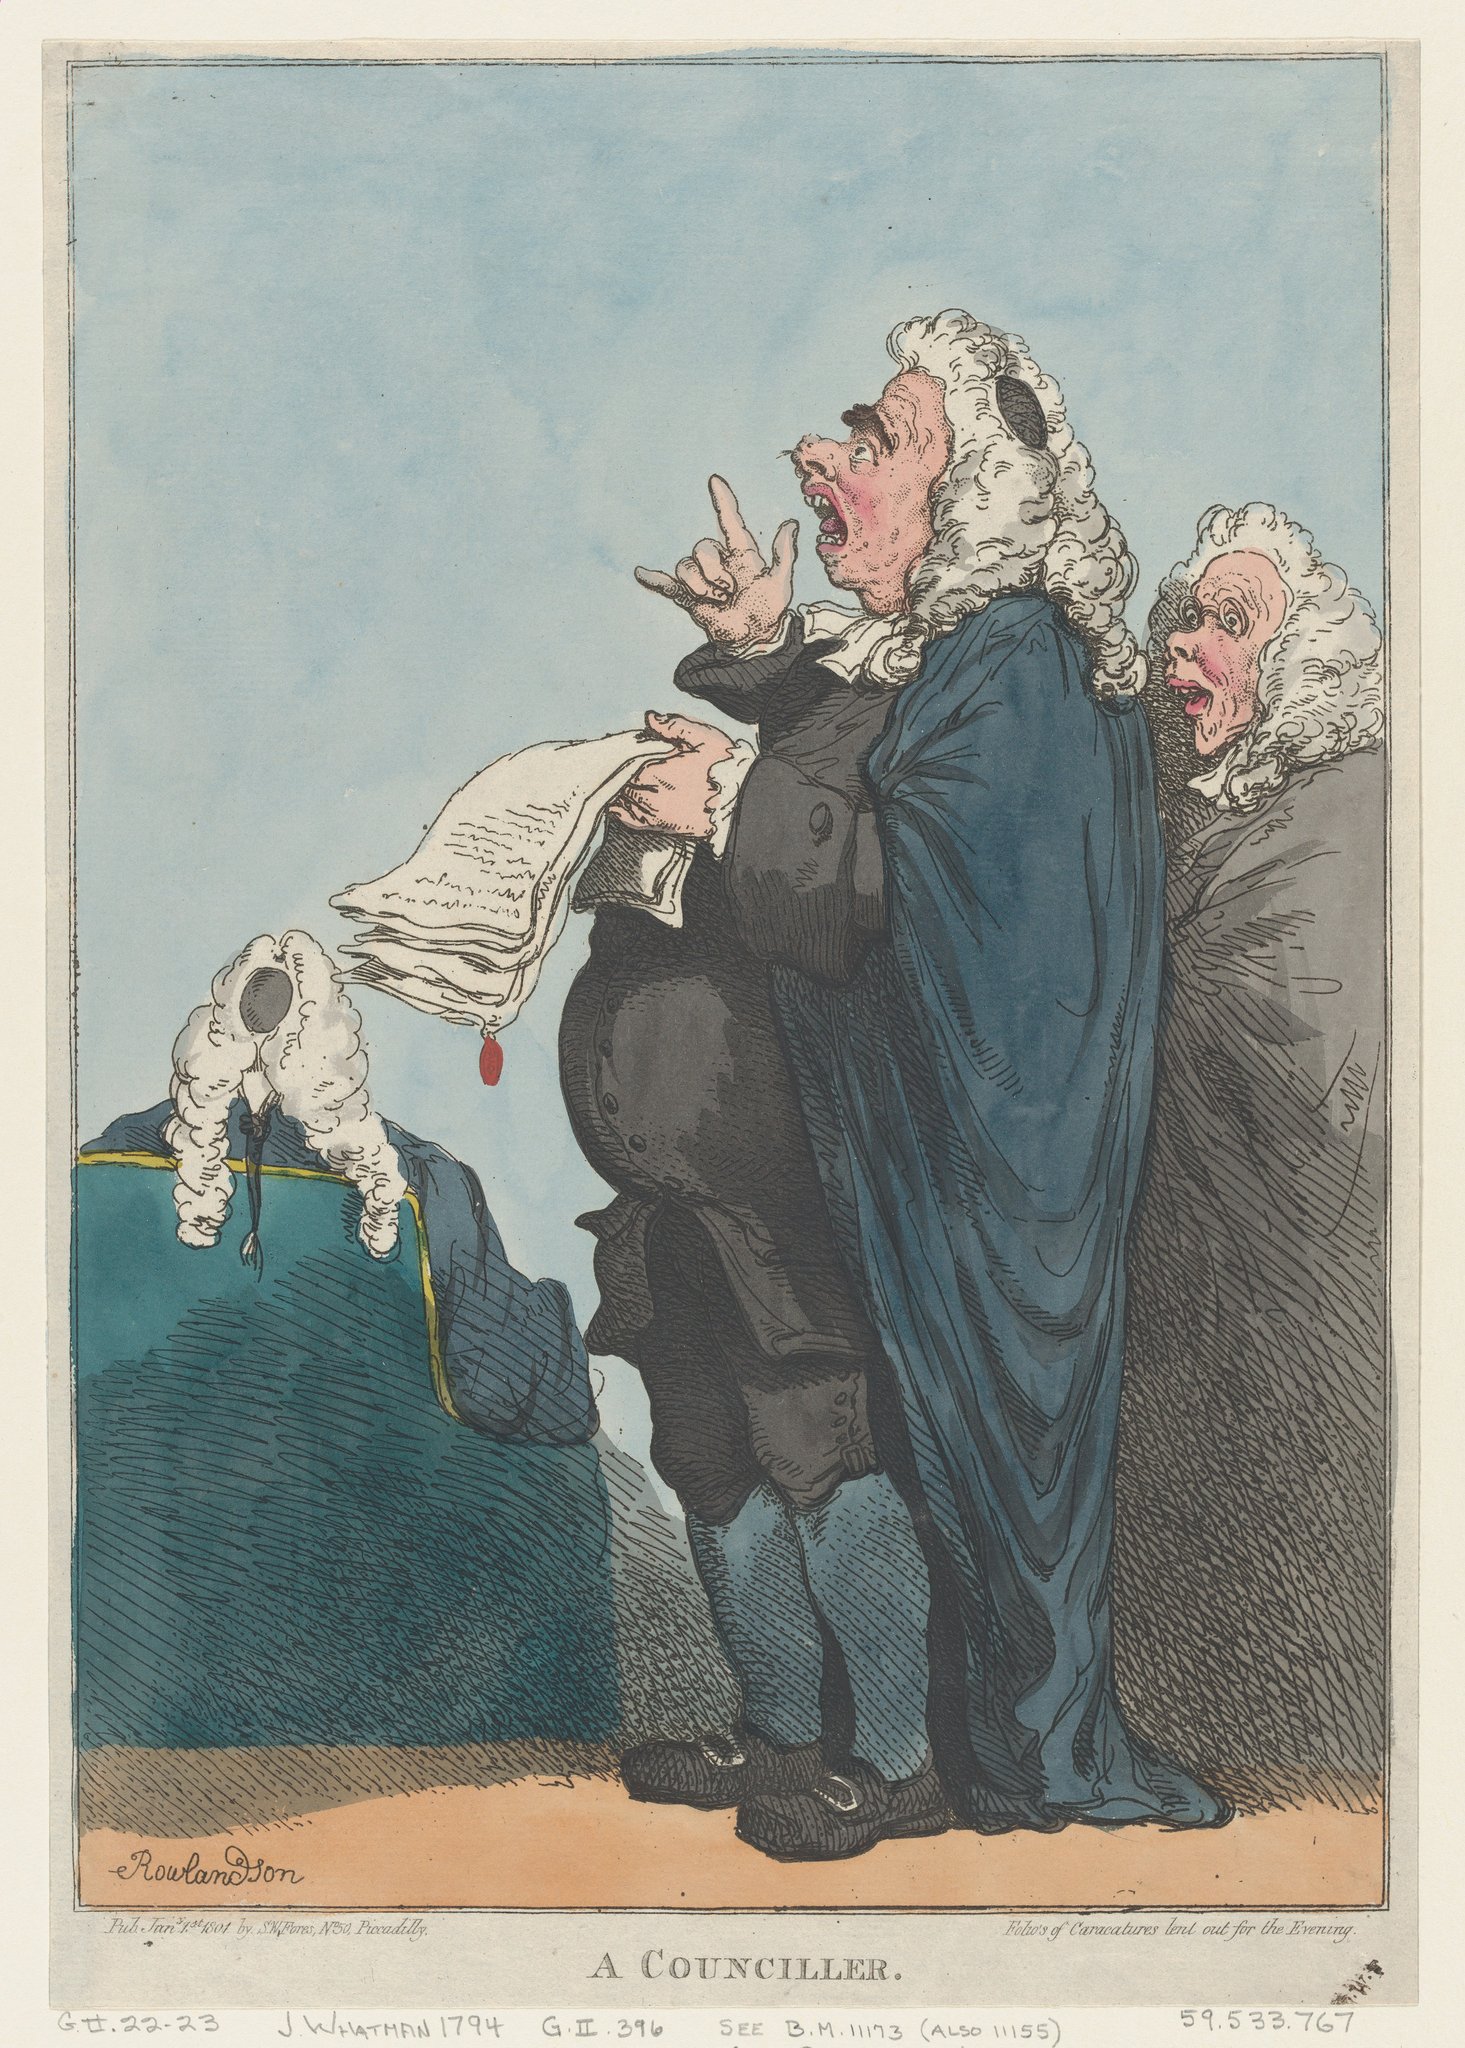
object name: print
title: A Counciller [sic]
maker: thomas rowlandson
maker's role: artist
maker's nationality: british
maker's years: 1757-1827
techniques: etching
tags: men